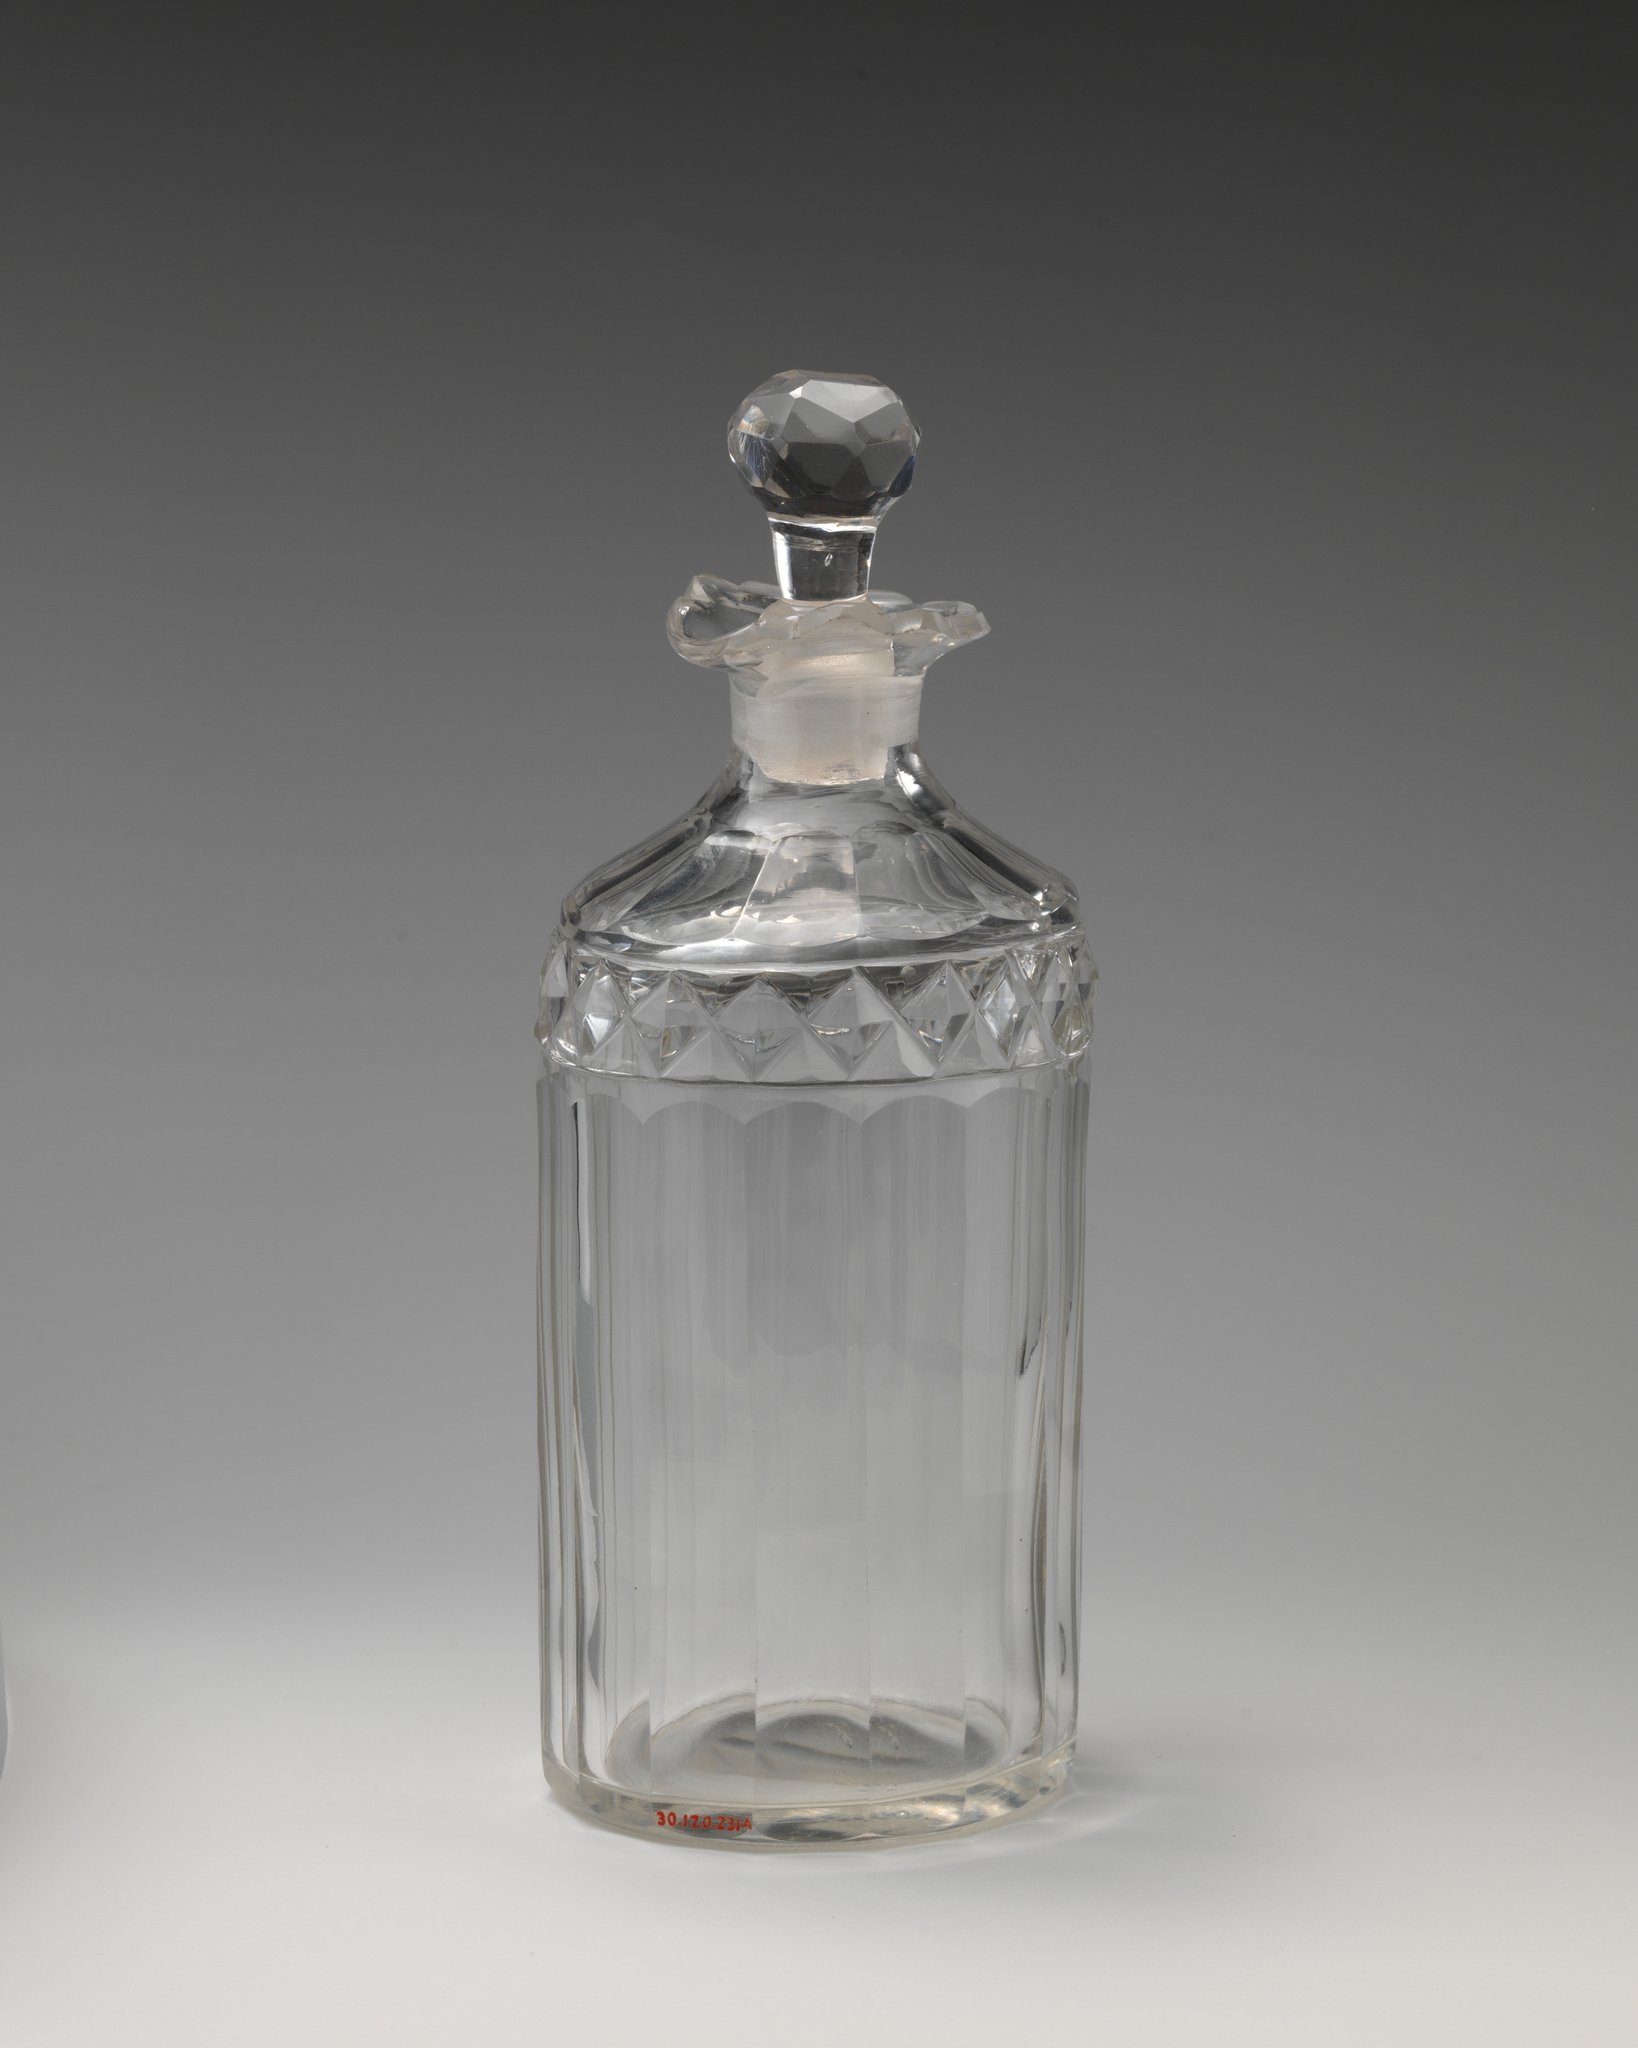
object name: liquor bottle with stopper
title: Liquor bottle with stopper (one of a pair)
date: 1801-1833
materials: glass